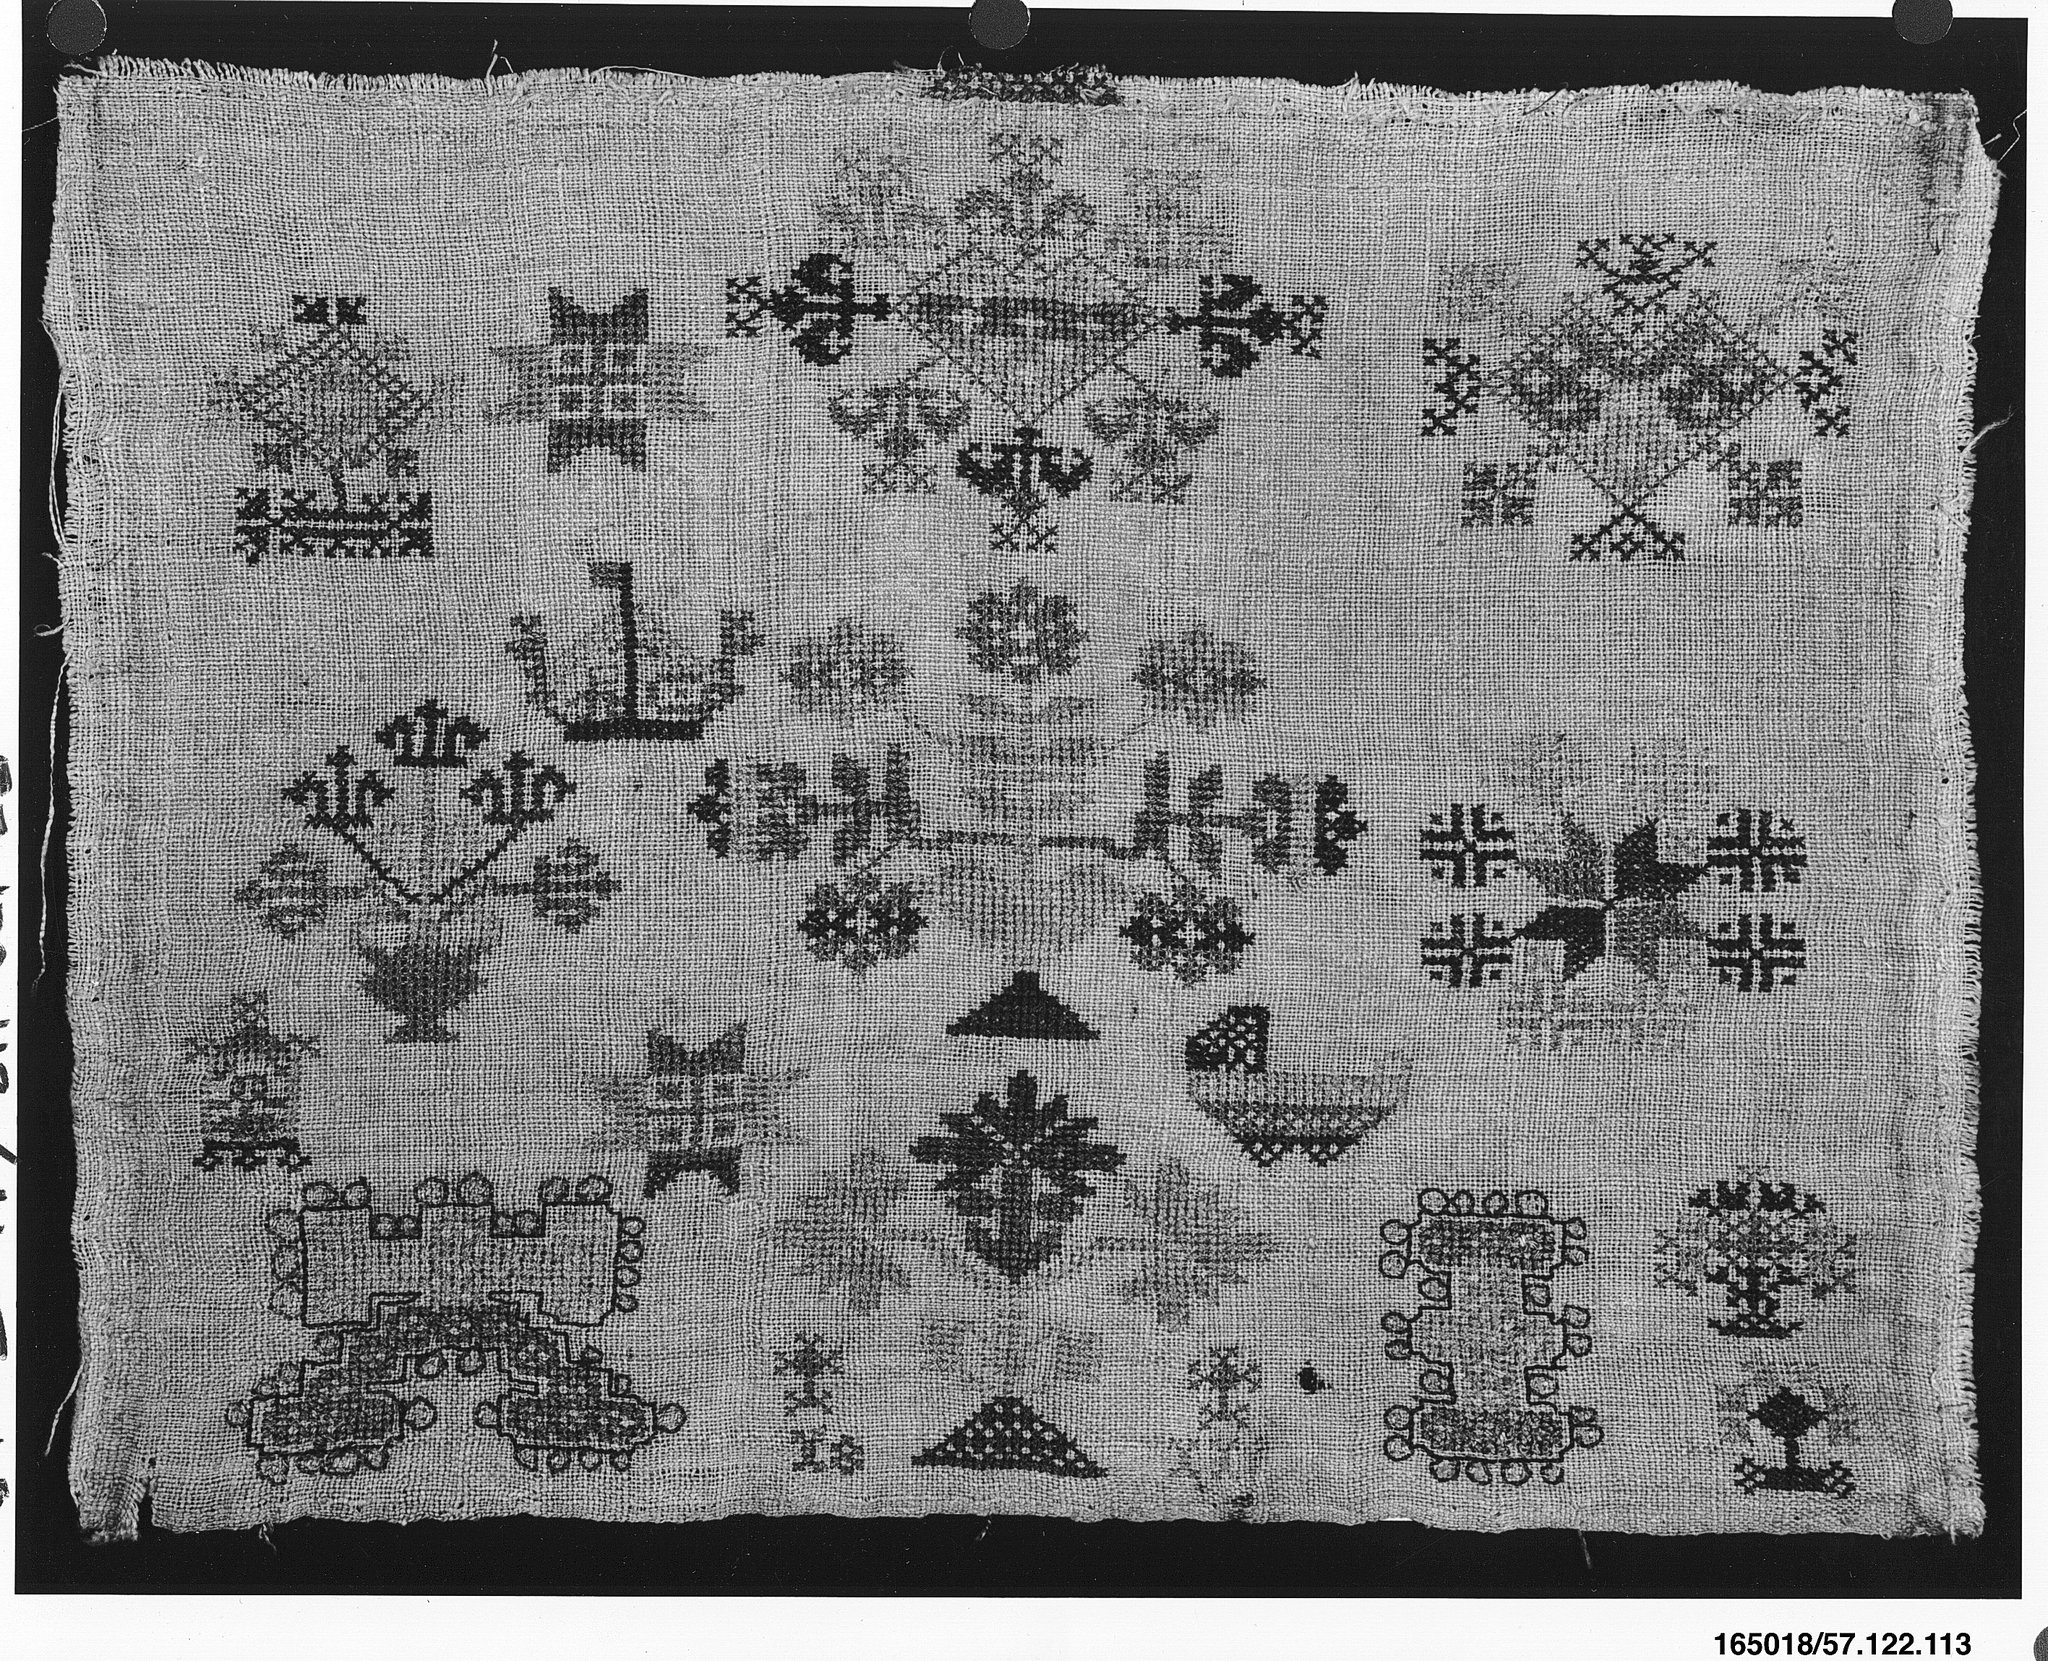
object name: sampler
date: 1811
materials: linen, silk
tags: flowers